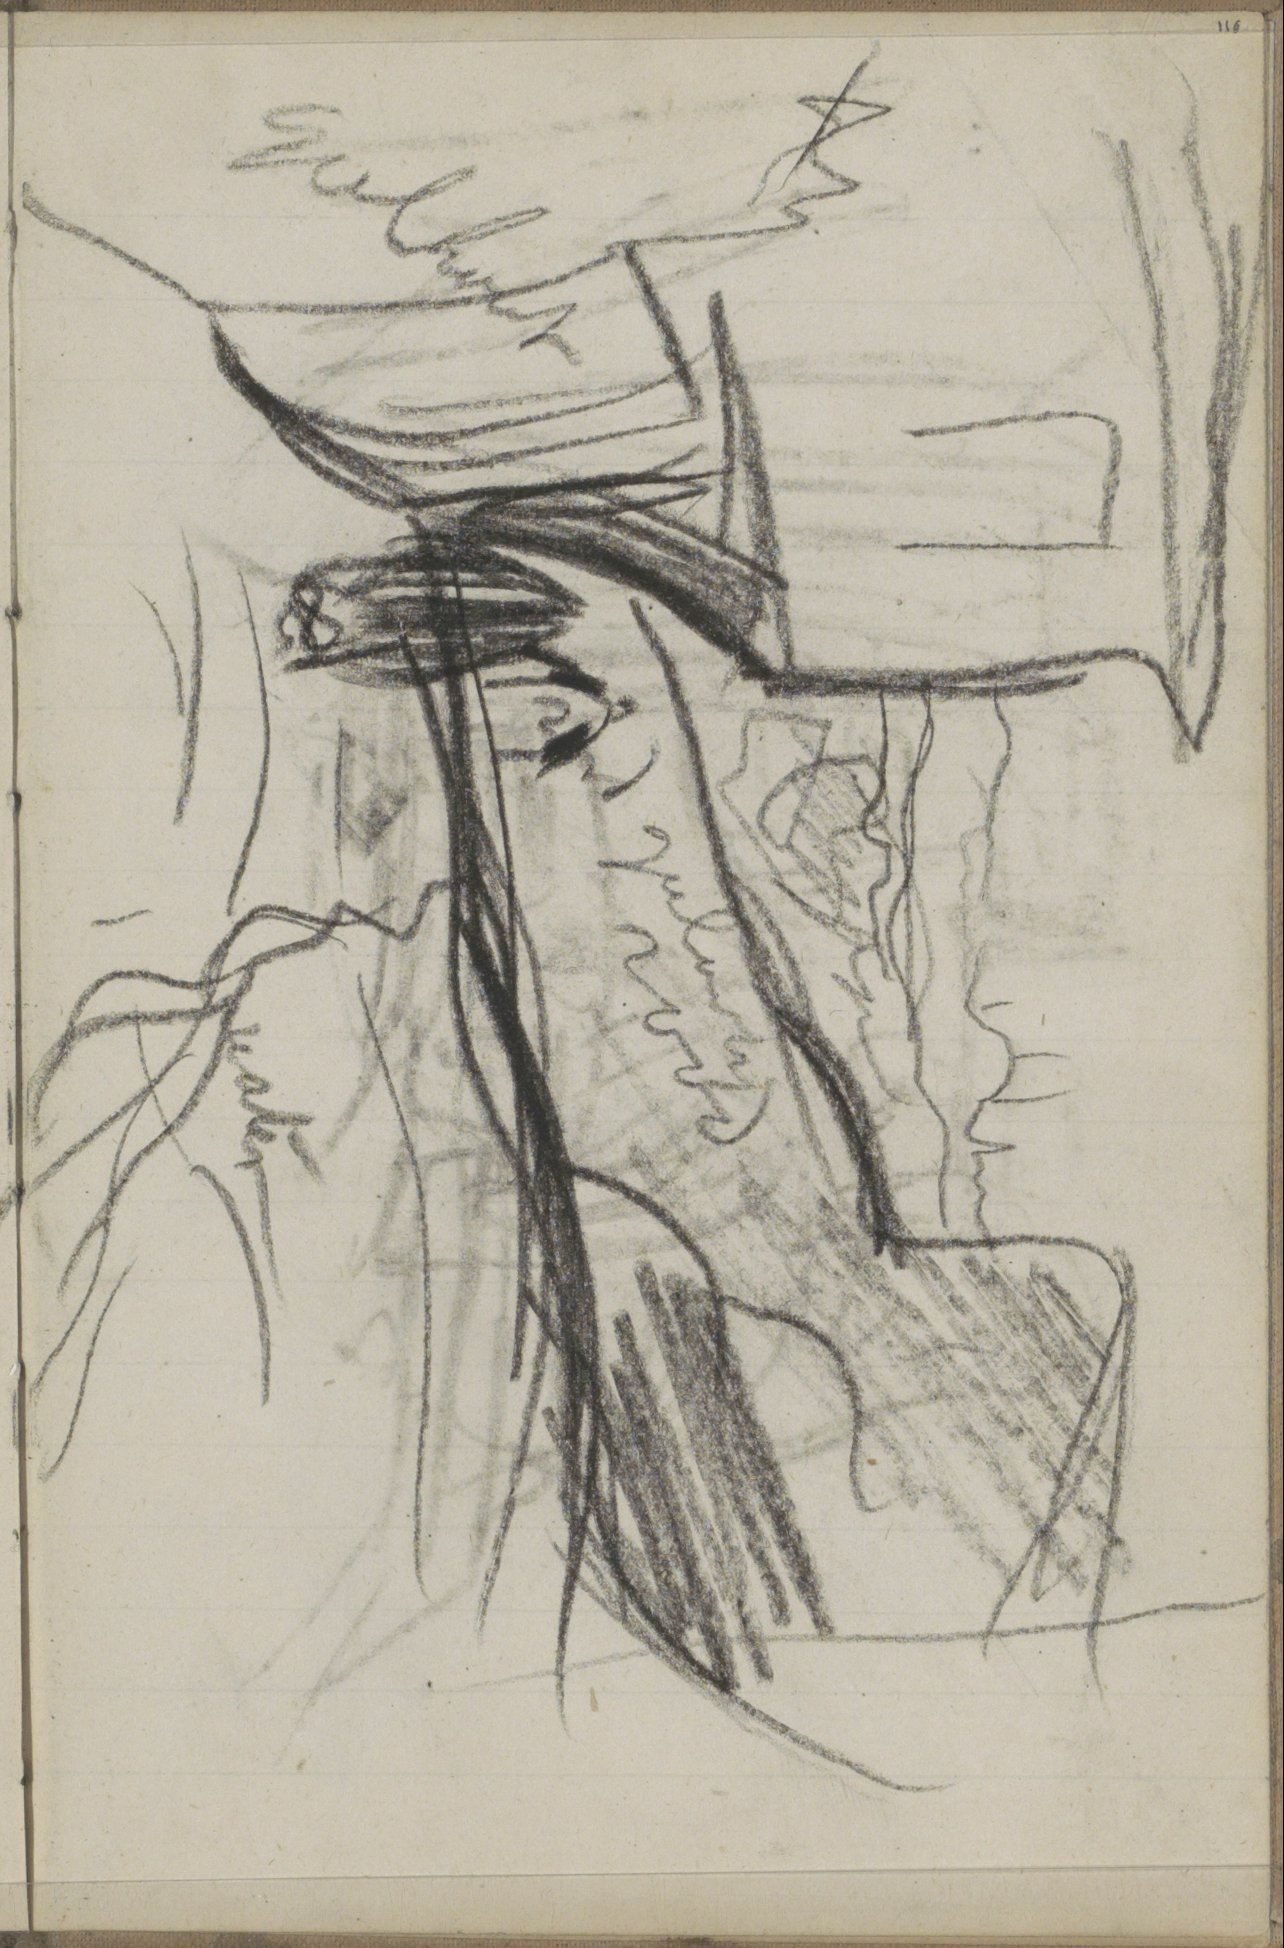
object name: sketchbook leaf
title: Straat met figuren en zicht op een landschap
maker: marius bauer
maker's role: draughtsman, print maker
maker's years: 1867-1932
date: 1888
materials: chalk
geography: istanbul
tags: city-view, and landscape with man-made constructions, street (+ city(-scape) with figures, staffage)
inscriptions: kleurnotitie, handgeschreven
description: Pagina 110 uit een schetsboek met 56 bladen.